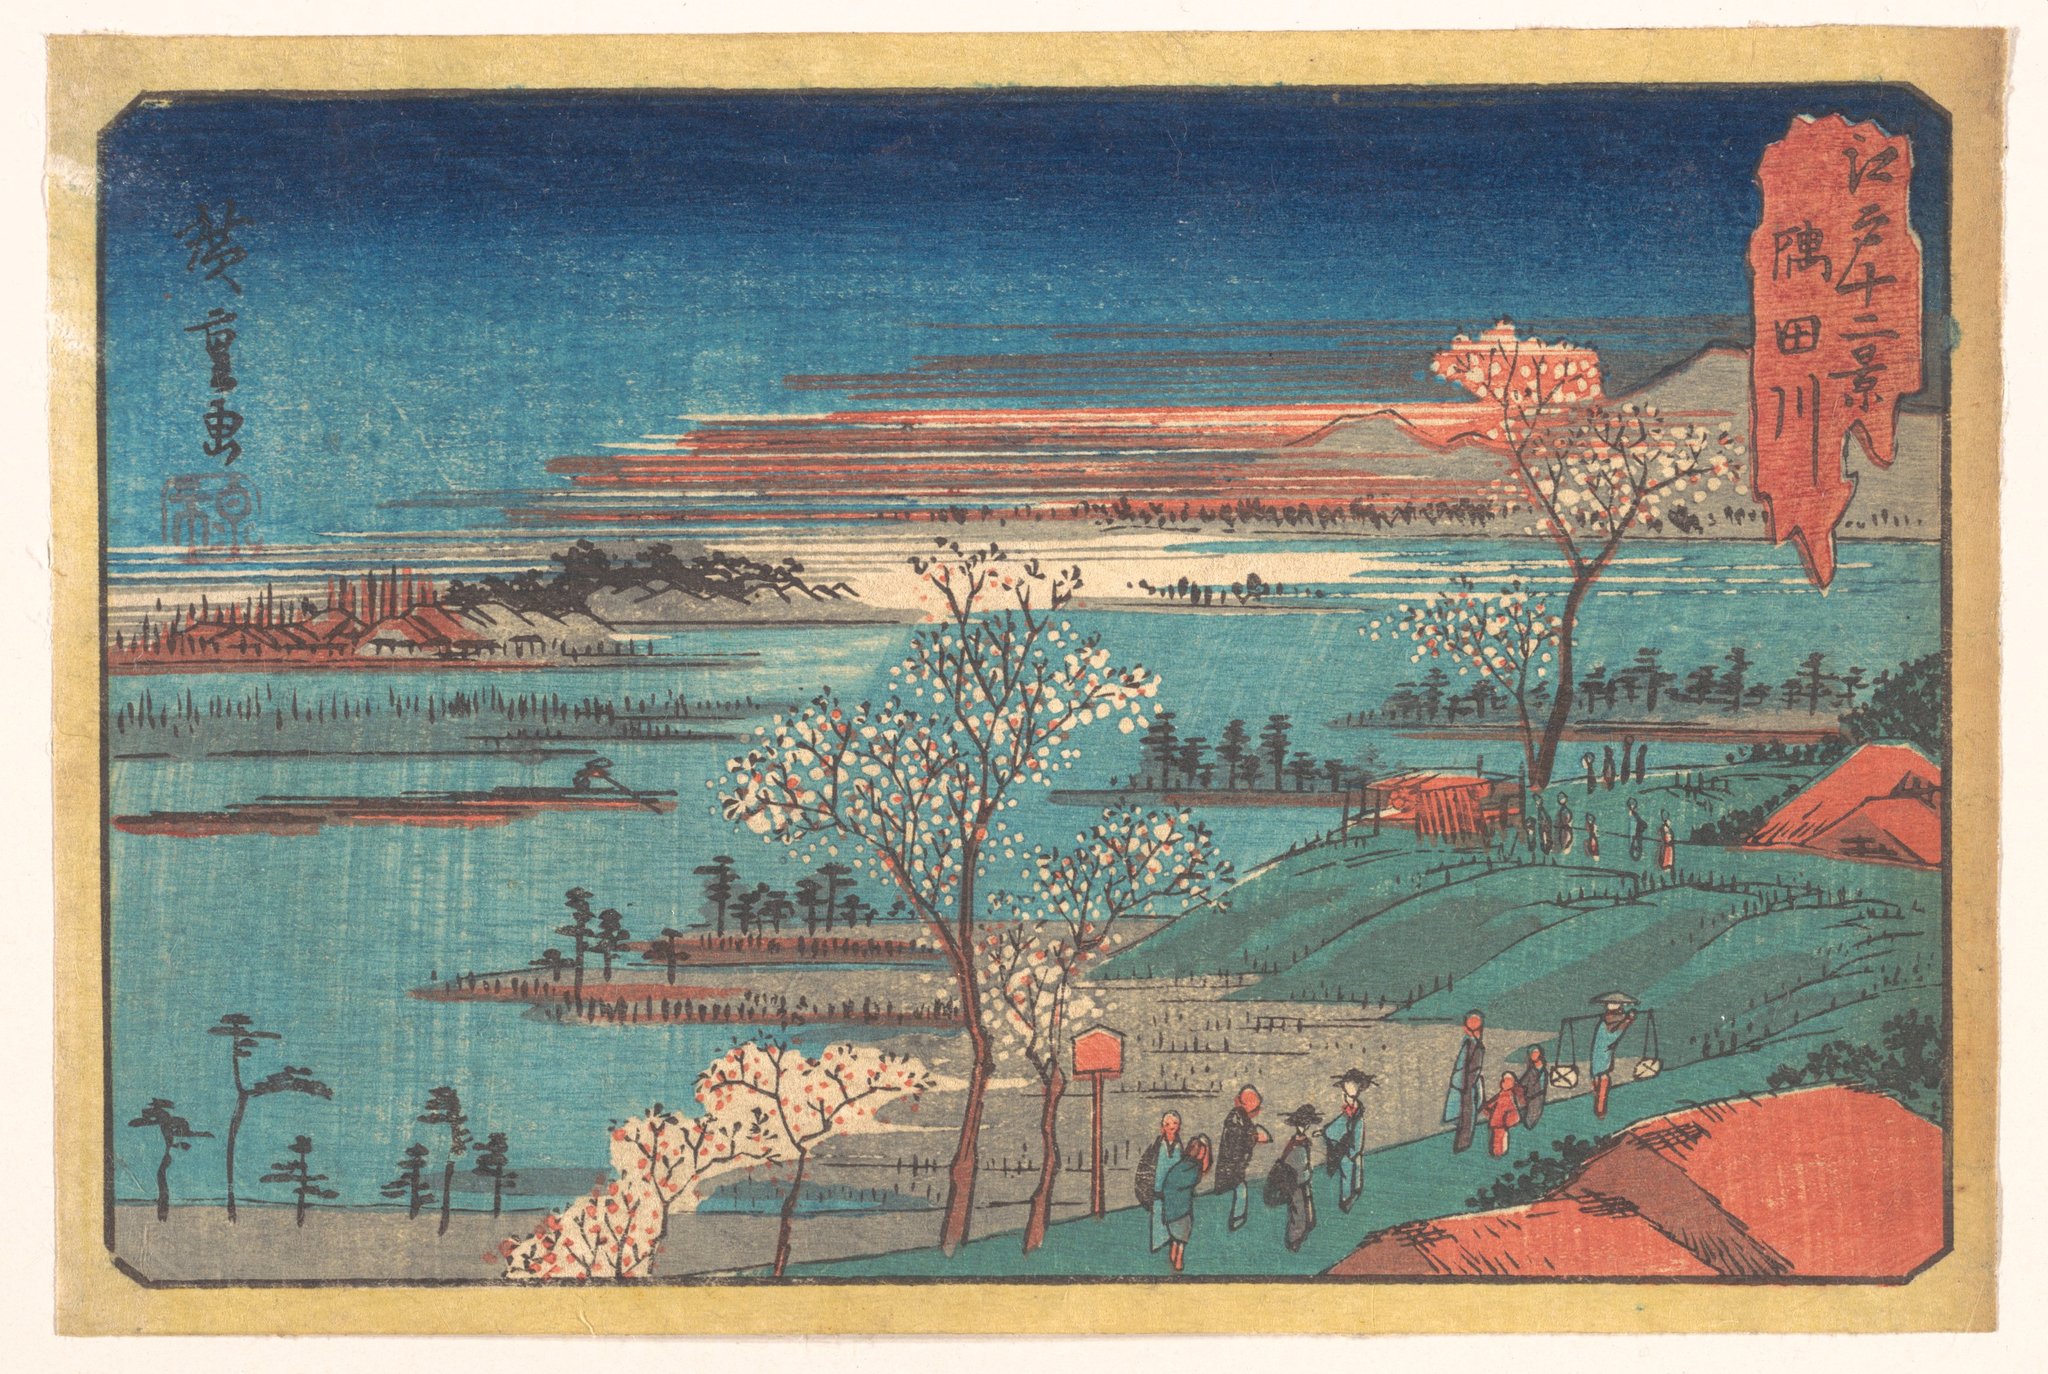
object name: print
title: Gotenyama-no Hana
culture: japanese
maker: utagawa hiroshige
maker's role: artist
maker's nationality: japanese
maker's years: 1797-1858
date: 1797-1858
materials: ink, paper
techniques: woodblock print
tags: human figures,mountains,landscapes